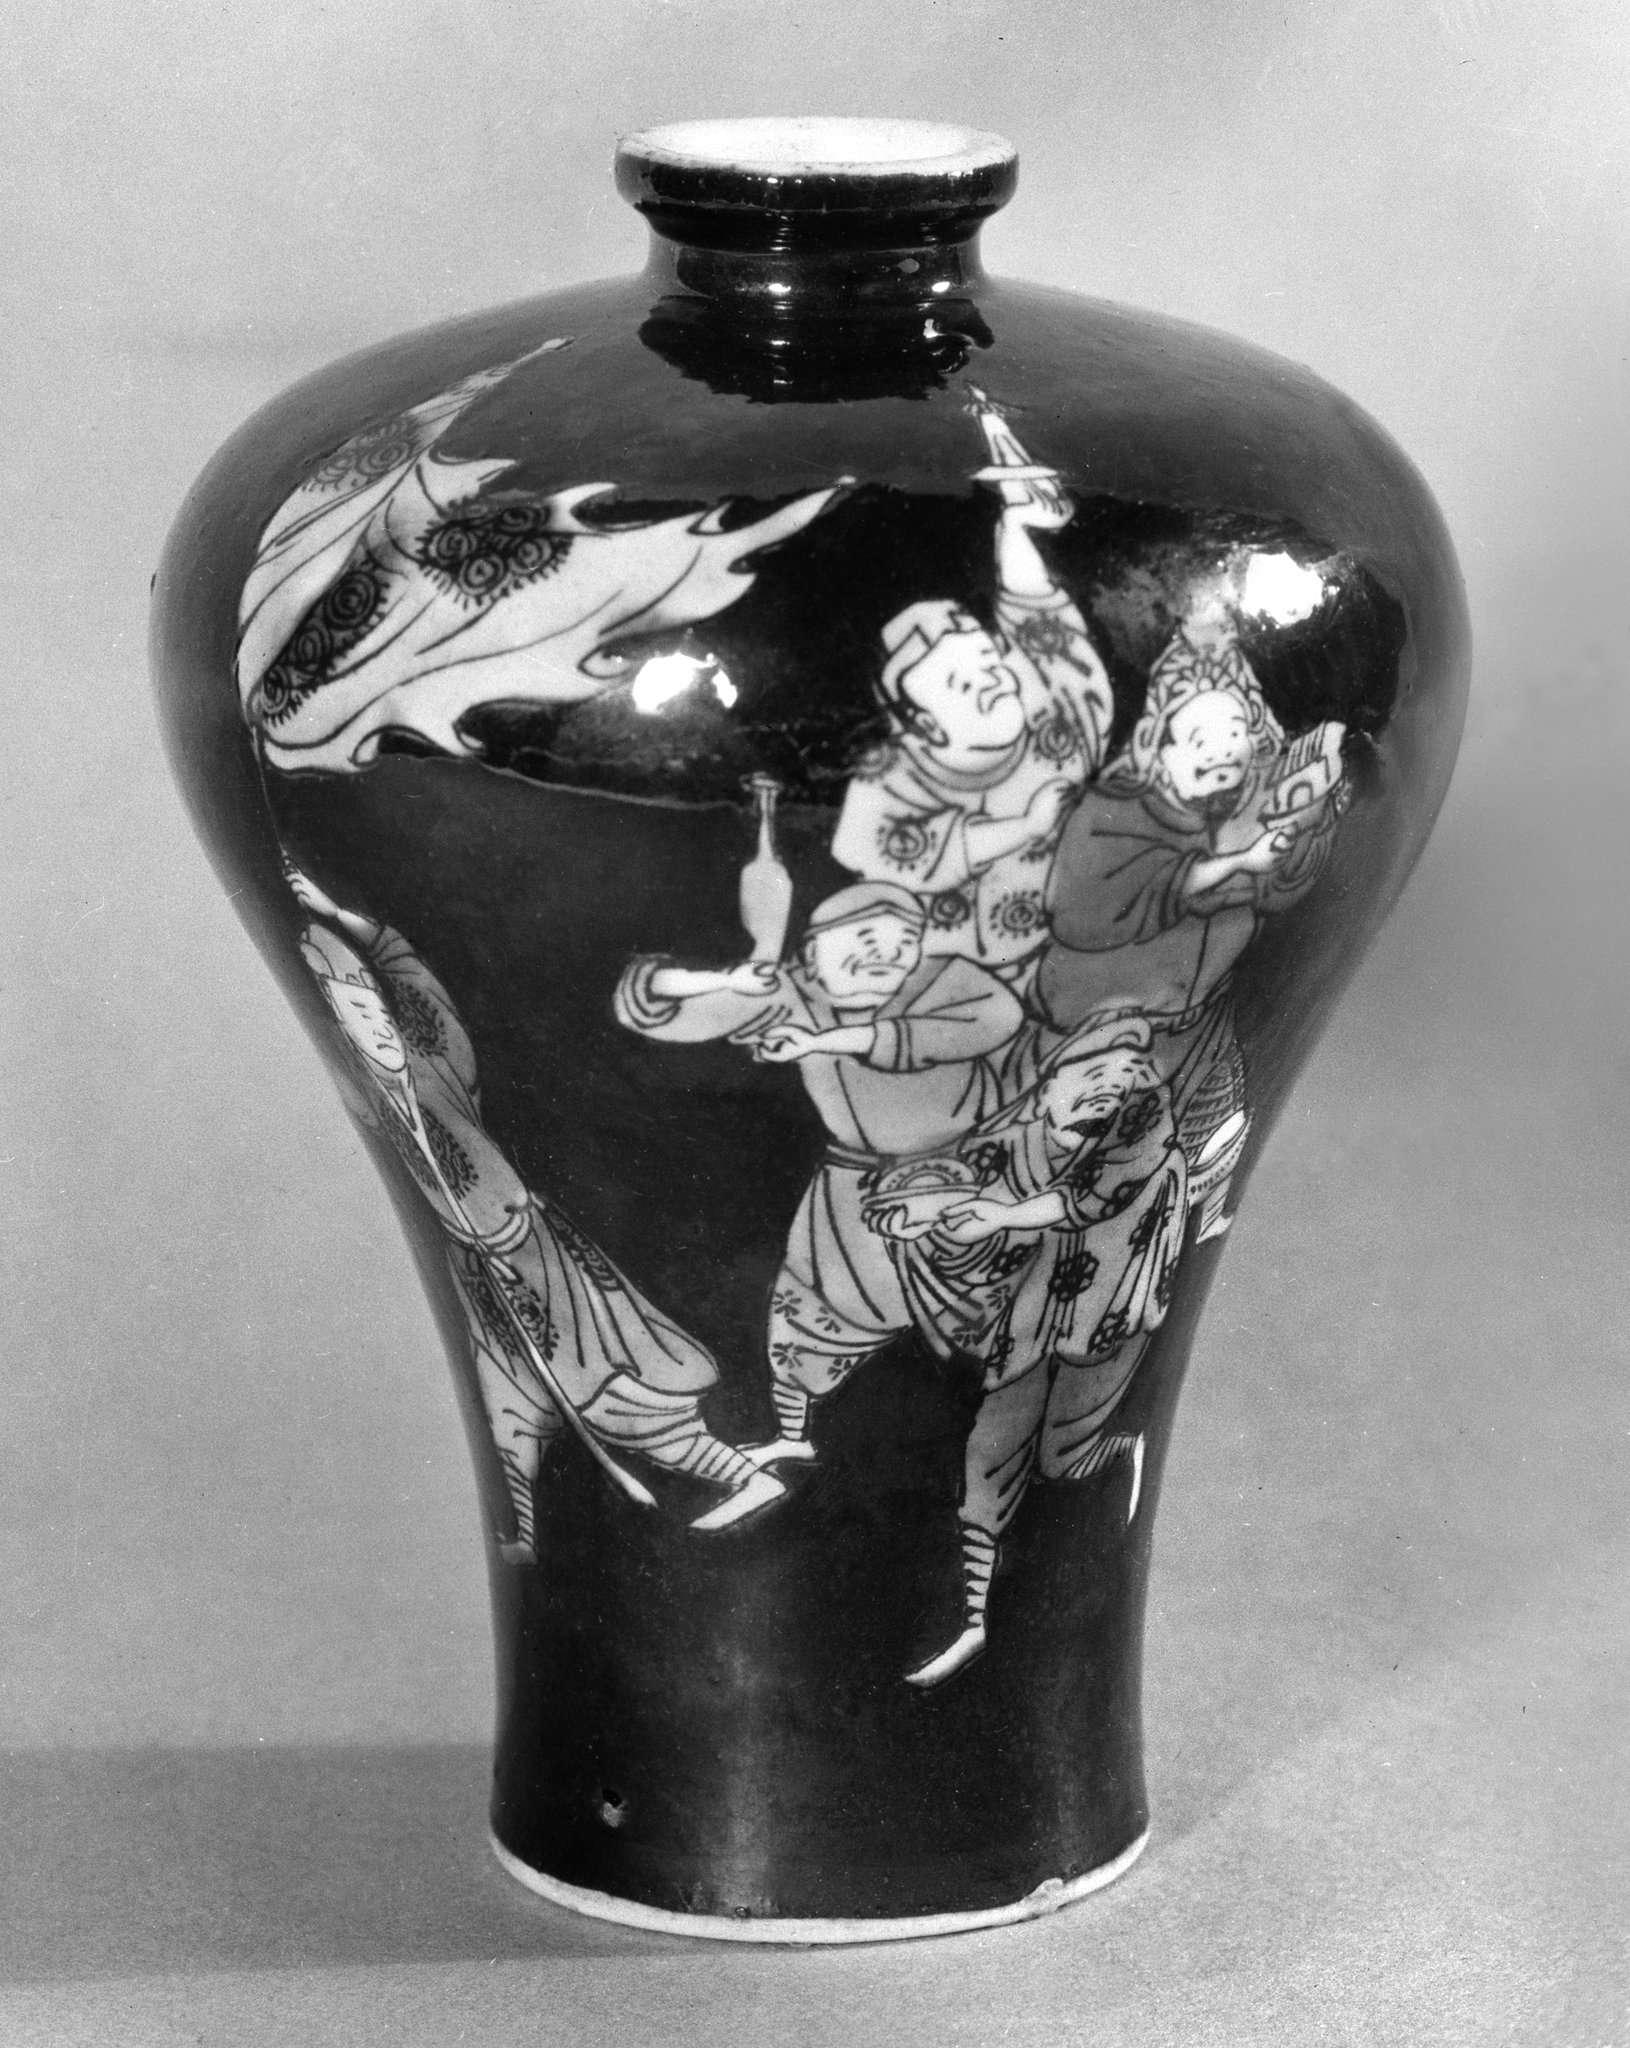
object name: vase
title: Meiping vase with human figures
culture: chinese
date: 1801-1900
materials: enamel, porcelain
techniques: overglaze, painting, polychrome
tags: men